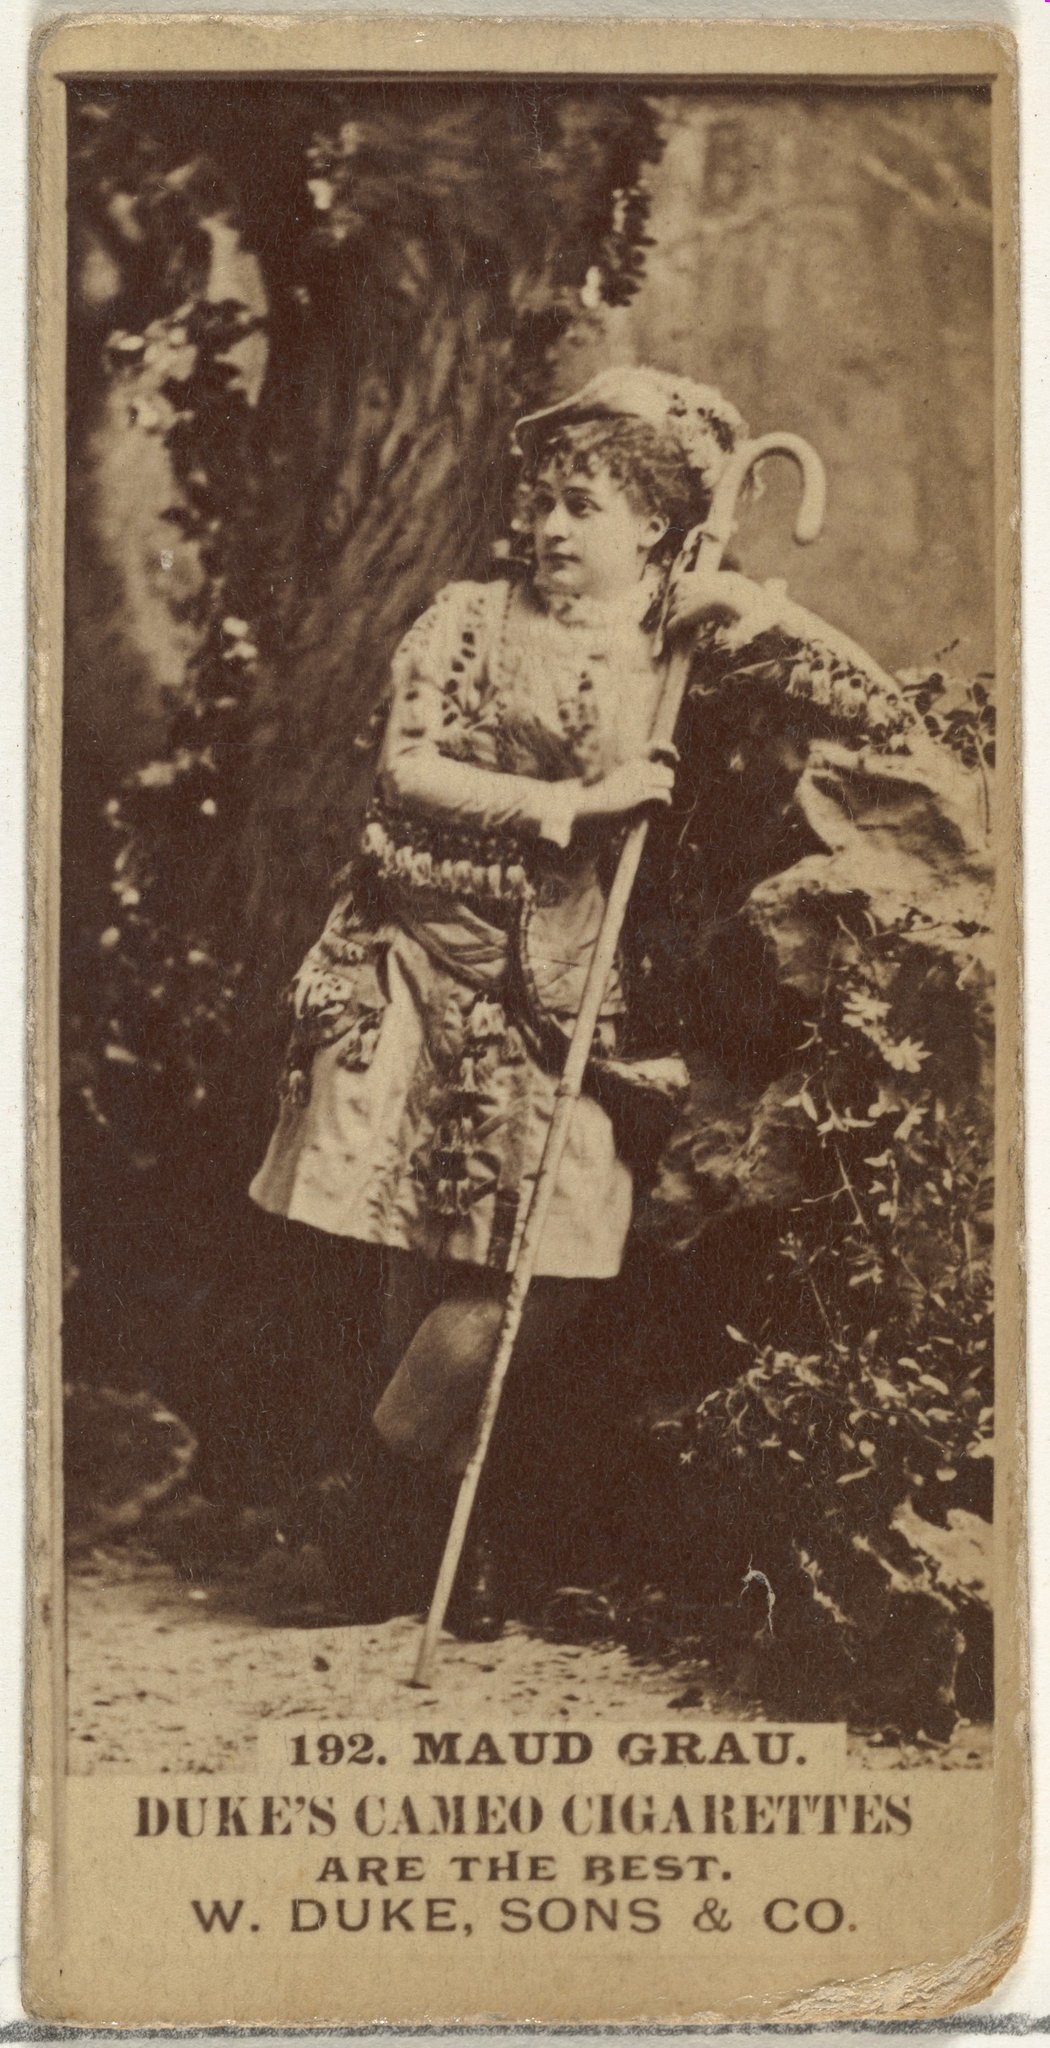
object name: photograph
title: Card Number 192, Maud Grau, from the Actors and Actresses series (N145-5) issued by Duke Sons & Co. to promote Cameo Cigarettes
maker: w. duke, sons & co.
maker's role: publisher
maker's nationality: american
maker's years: 1870-1920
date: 1880-1889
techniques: albumen silver print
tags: portraits,women,actresses